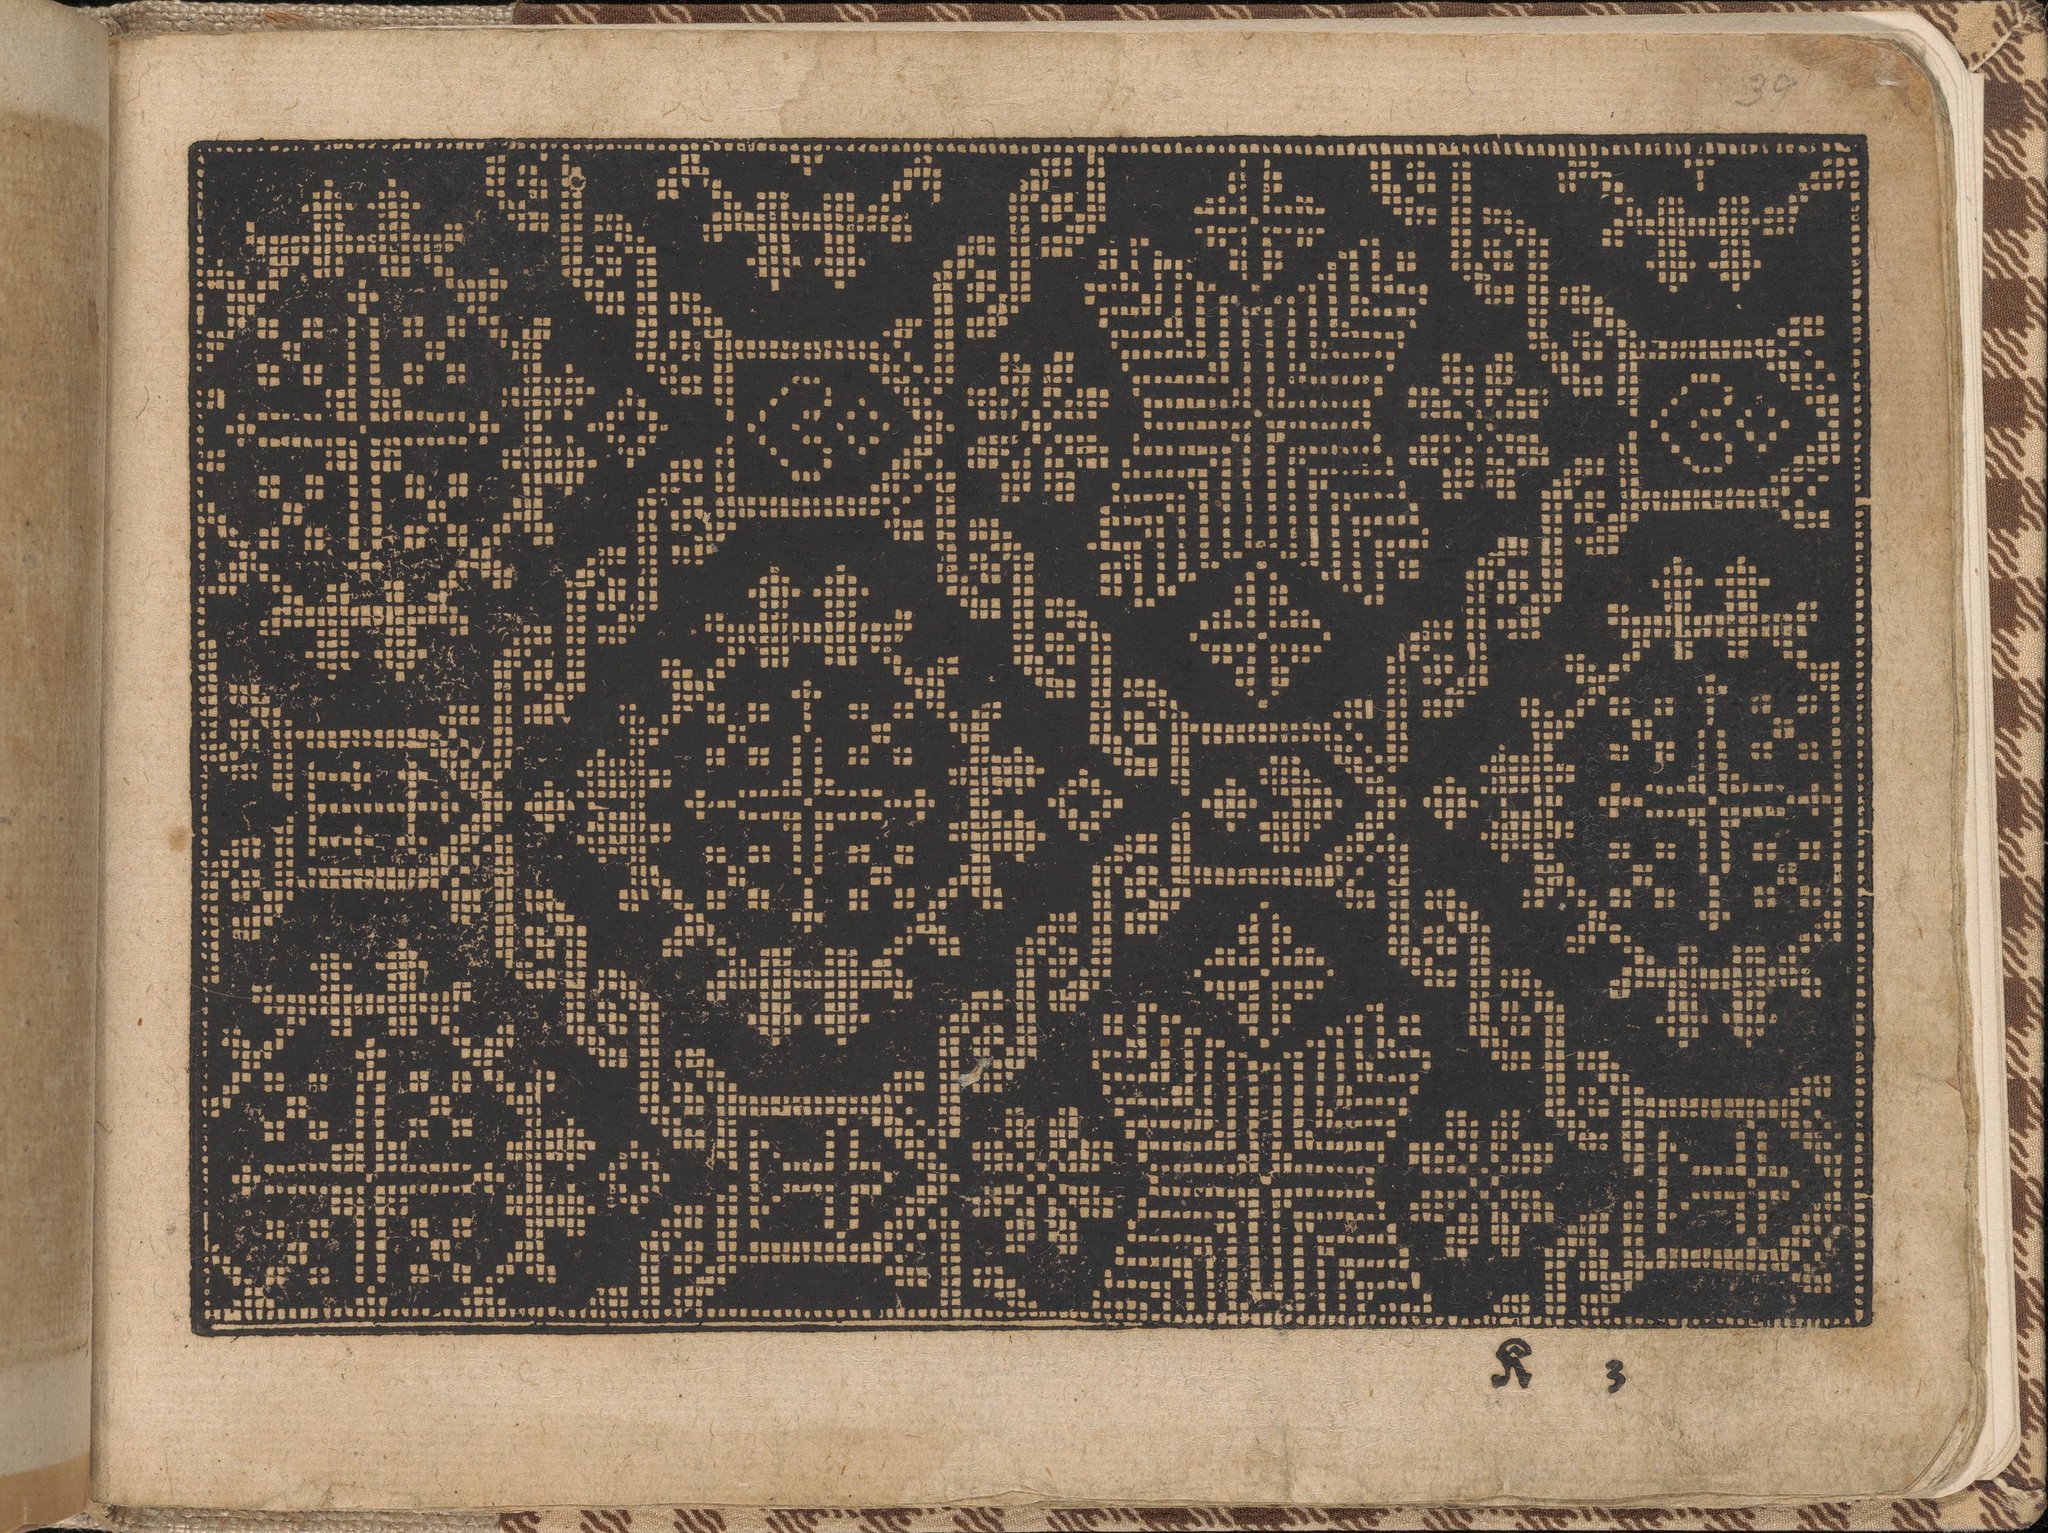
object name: book print ornament architecture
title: New Künstlichs Modelbuch (Page 39 recto)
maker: bernhard jobin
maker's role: publisher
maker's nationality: swiss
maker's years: 1535-1597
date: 1600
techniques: woodcut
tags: ornament